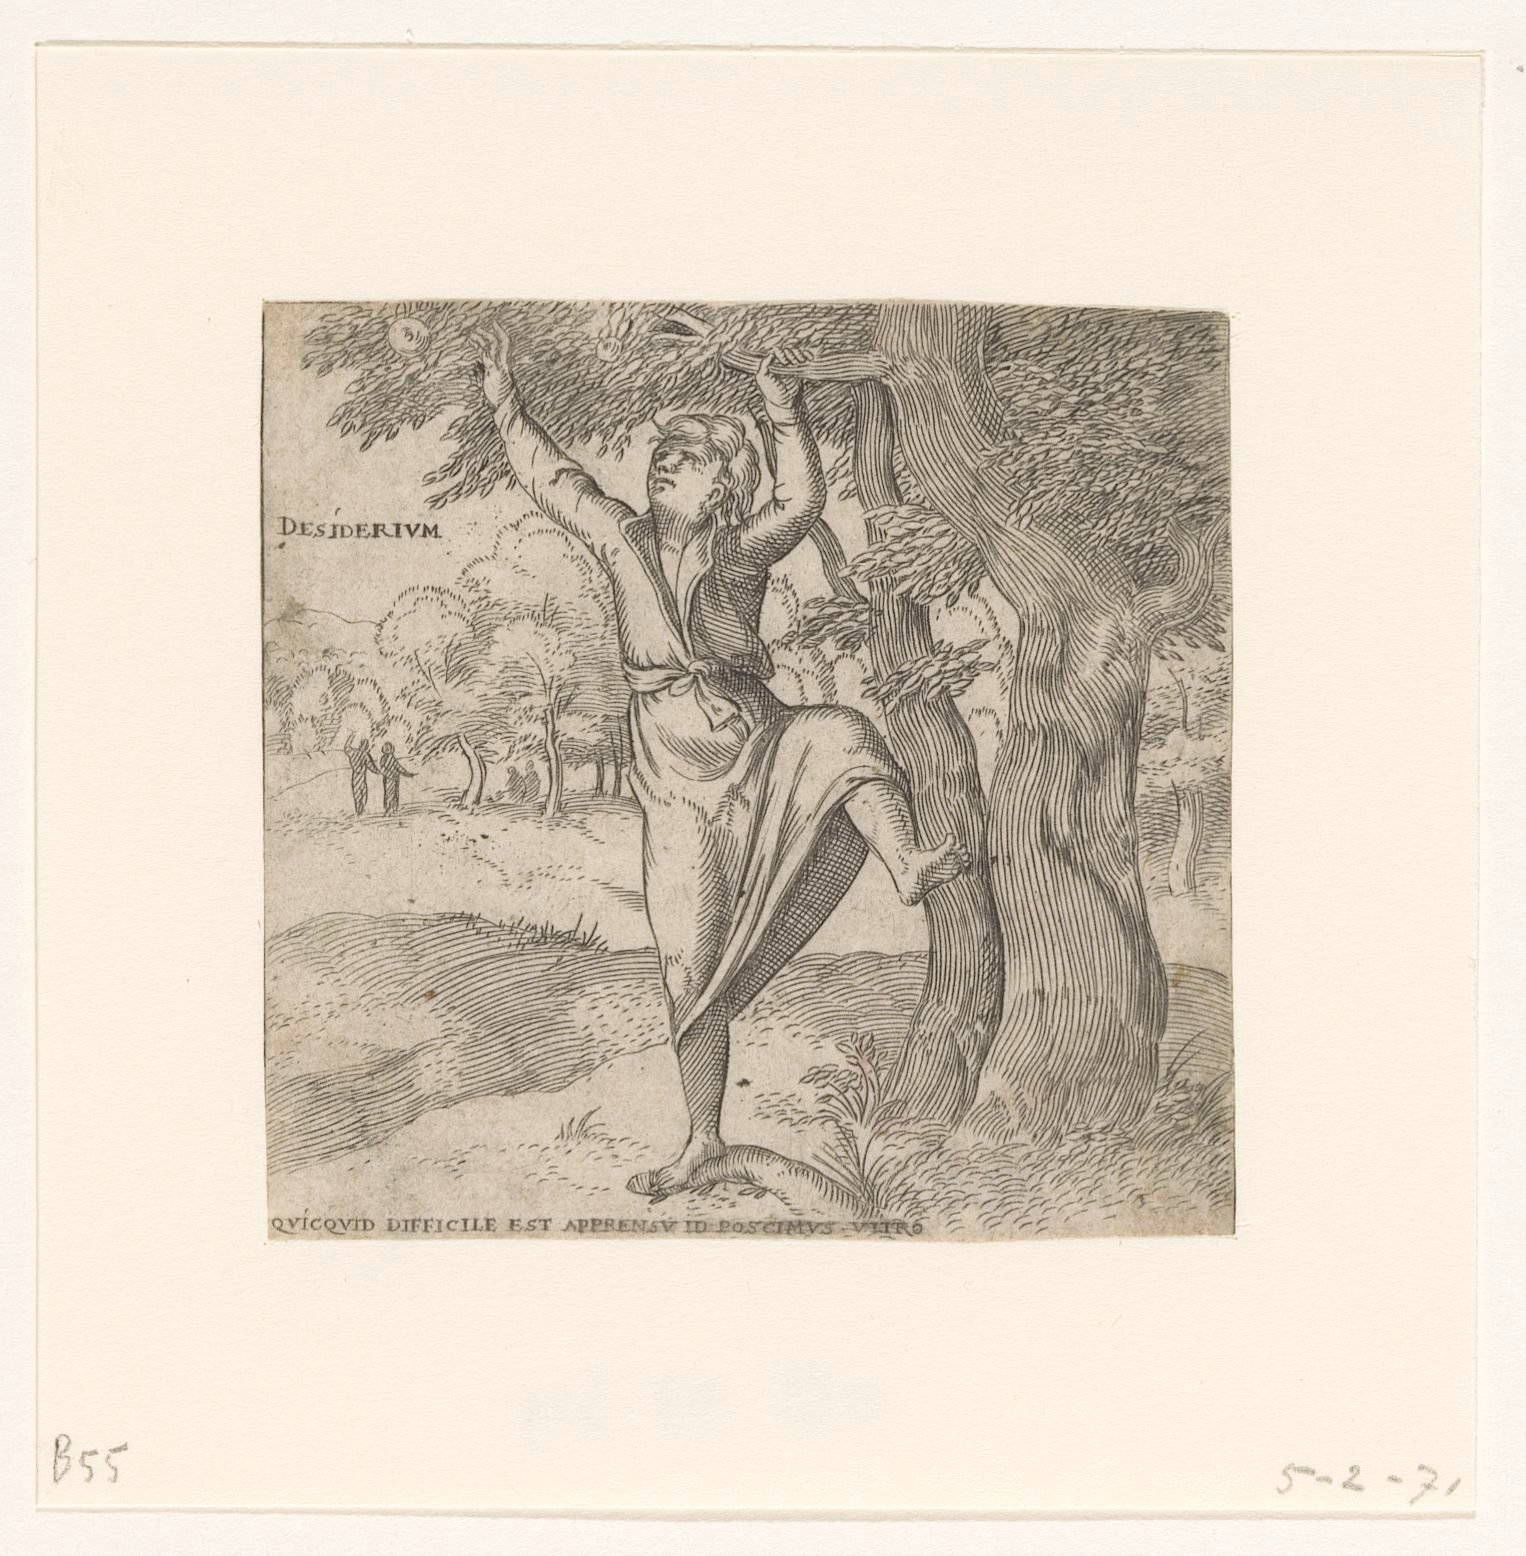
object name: print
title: Emblematische figuren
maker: francesco salviati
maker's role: draughtsman, painter, print maker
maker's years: 1510-1563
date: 1533-1567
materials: paper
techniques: engraving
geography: italy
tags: picking fruit, desire; 'desiderio' (ripa)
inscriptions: collector's mark: Lugt 240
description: Verlangen (Desiderio) als jongeman die zich uitstrekt om vruchten van een boom te plukken. Onderaan een regel Latijnse tekst.